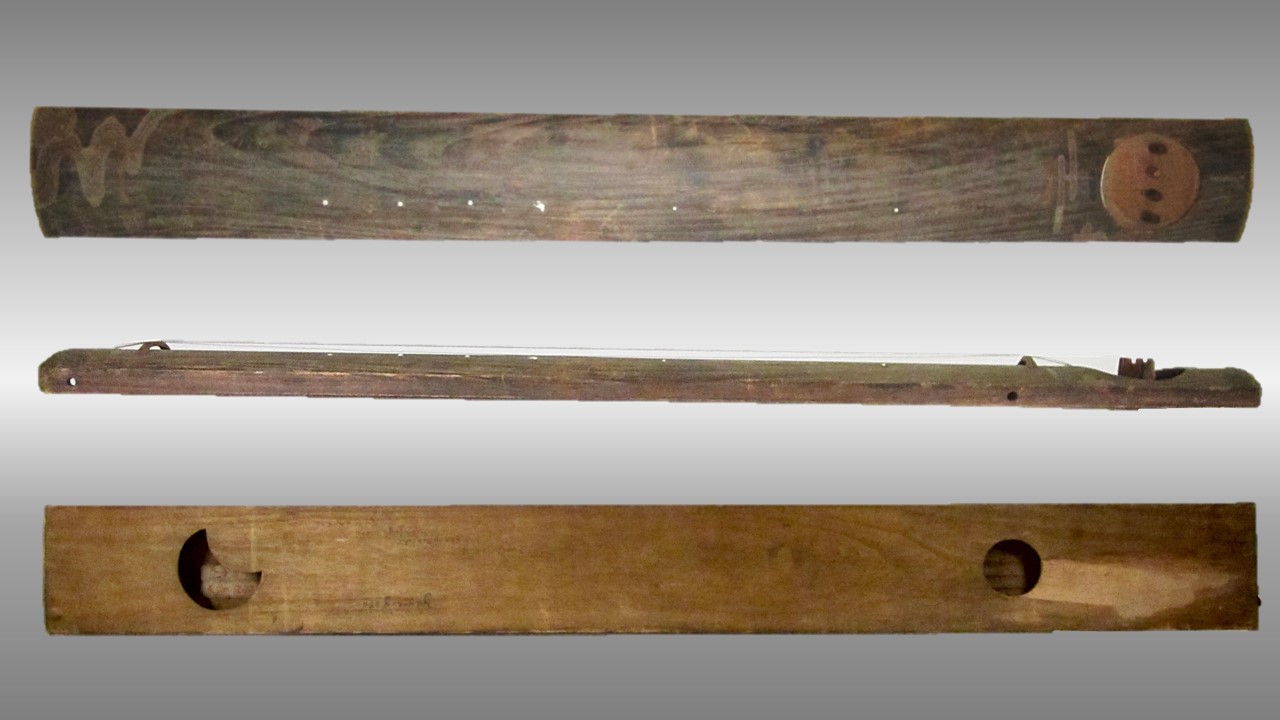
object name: yayoi goto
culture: japanese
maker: asano tōshichi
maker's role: maker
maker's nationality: japanese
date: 1801-1900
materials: silk, wood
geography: japan